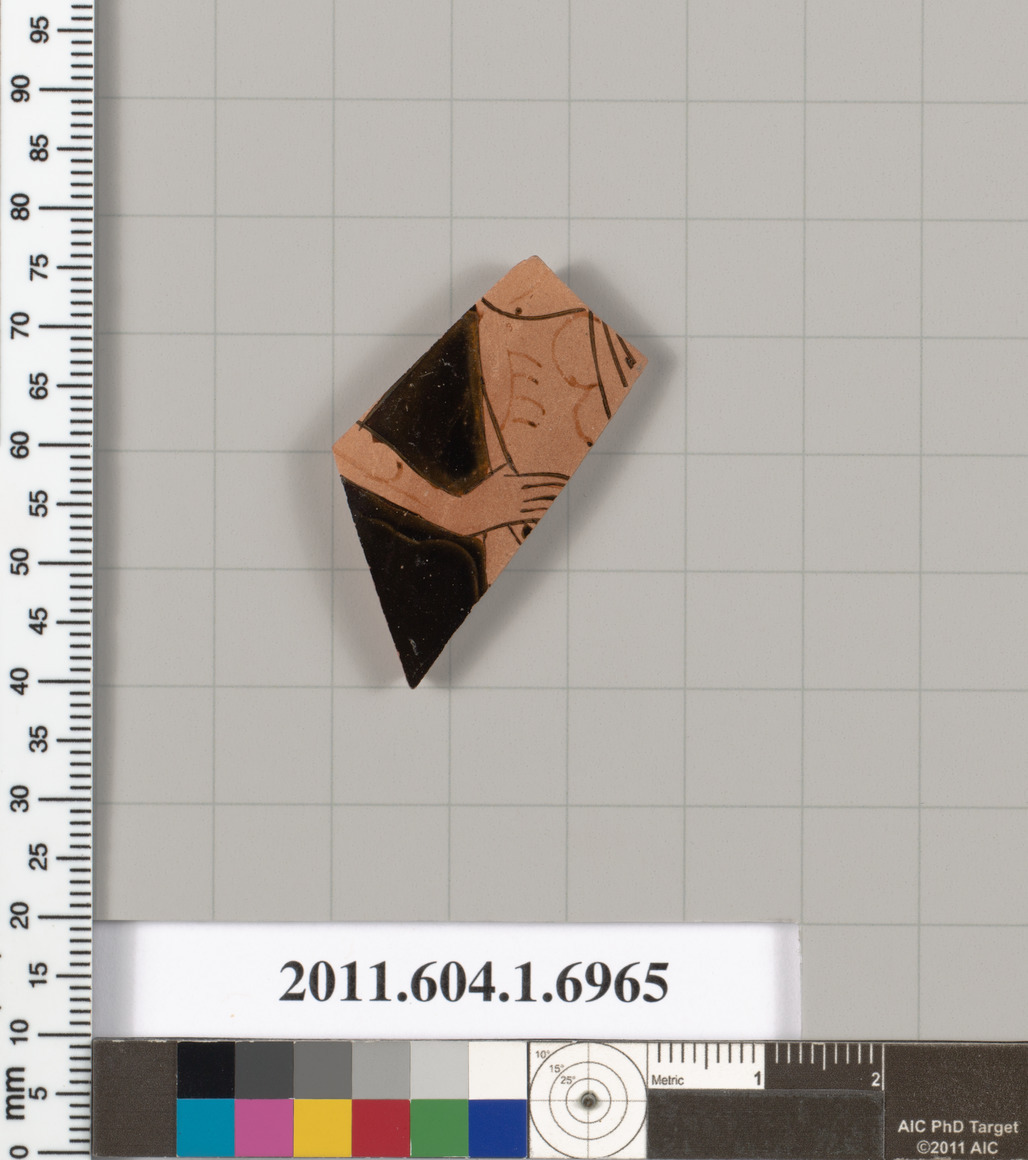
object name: kylix fragment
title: Terracotta fragment of a kylix (drinking cup)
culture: greek, attic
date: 490-470 BCE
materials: terracotta